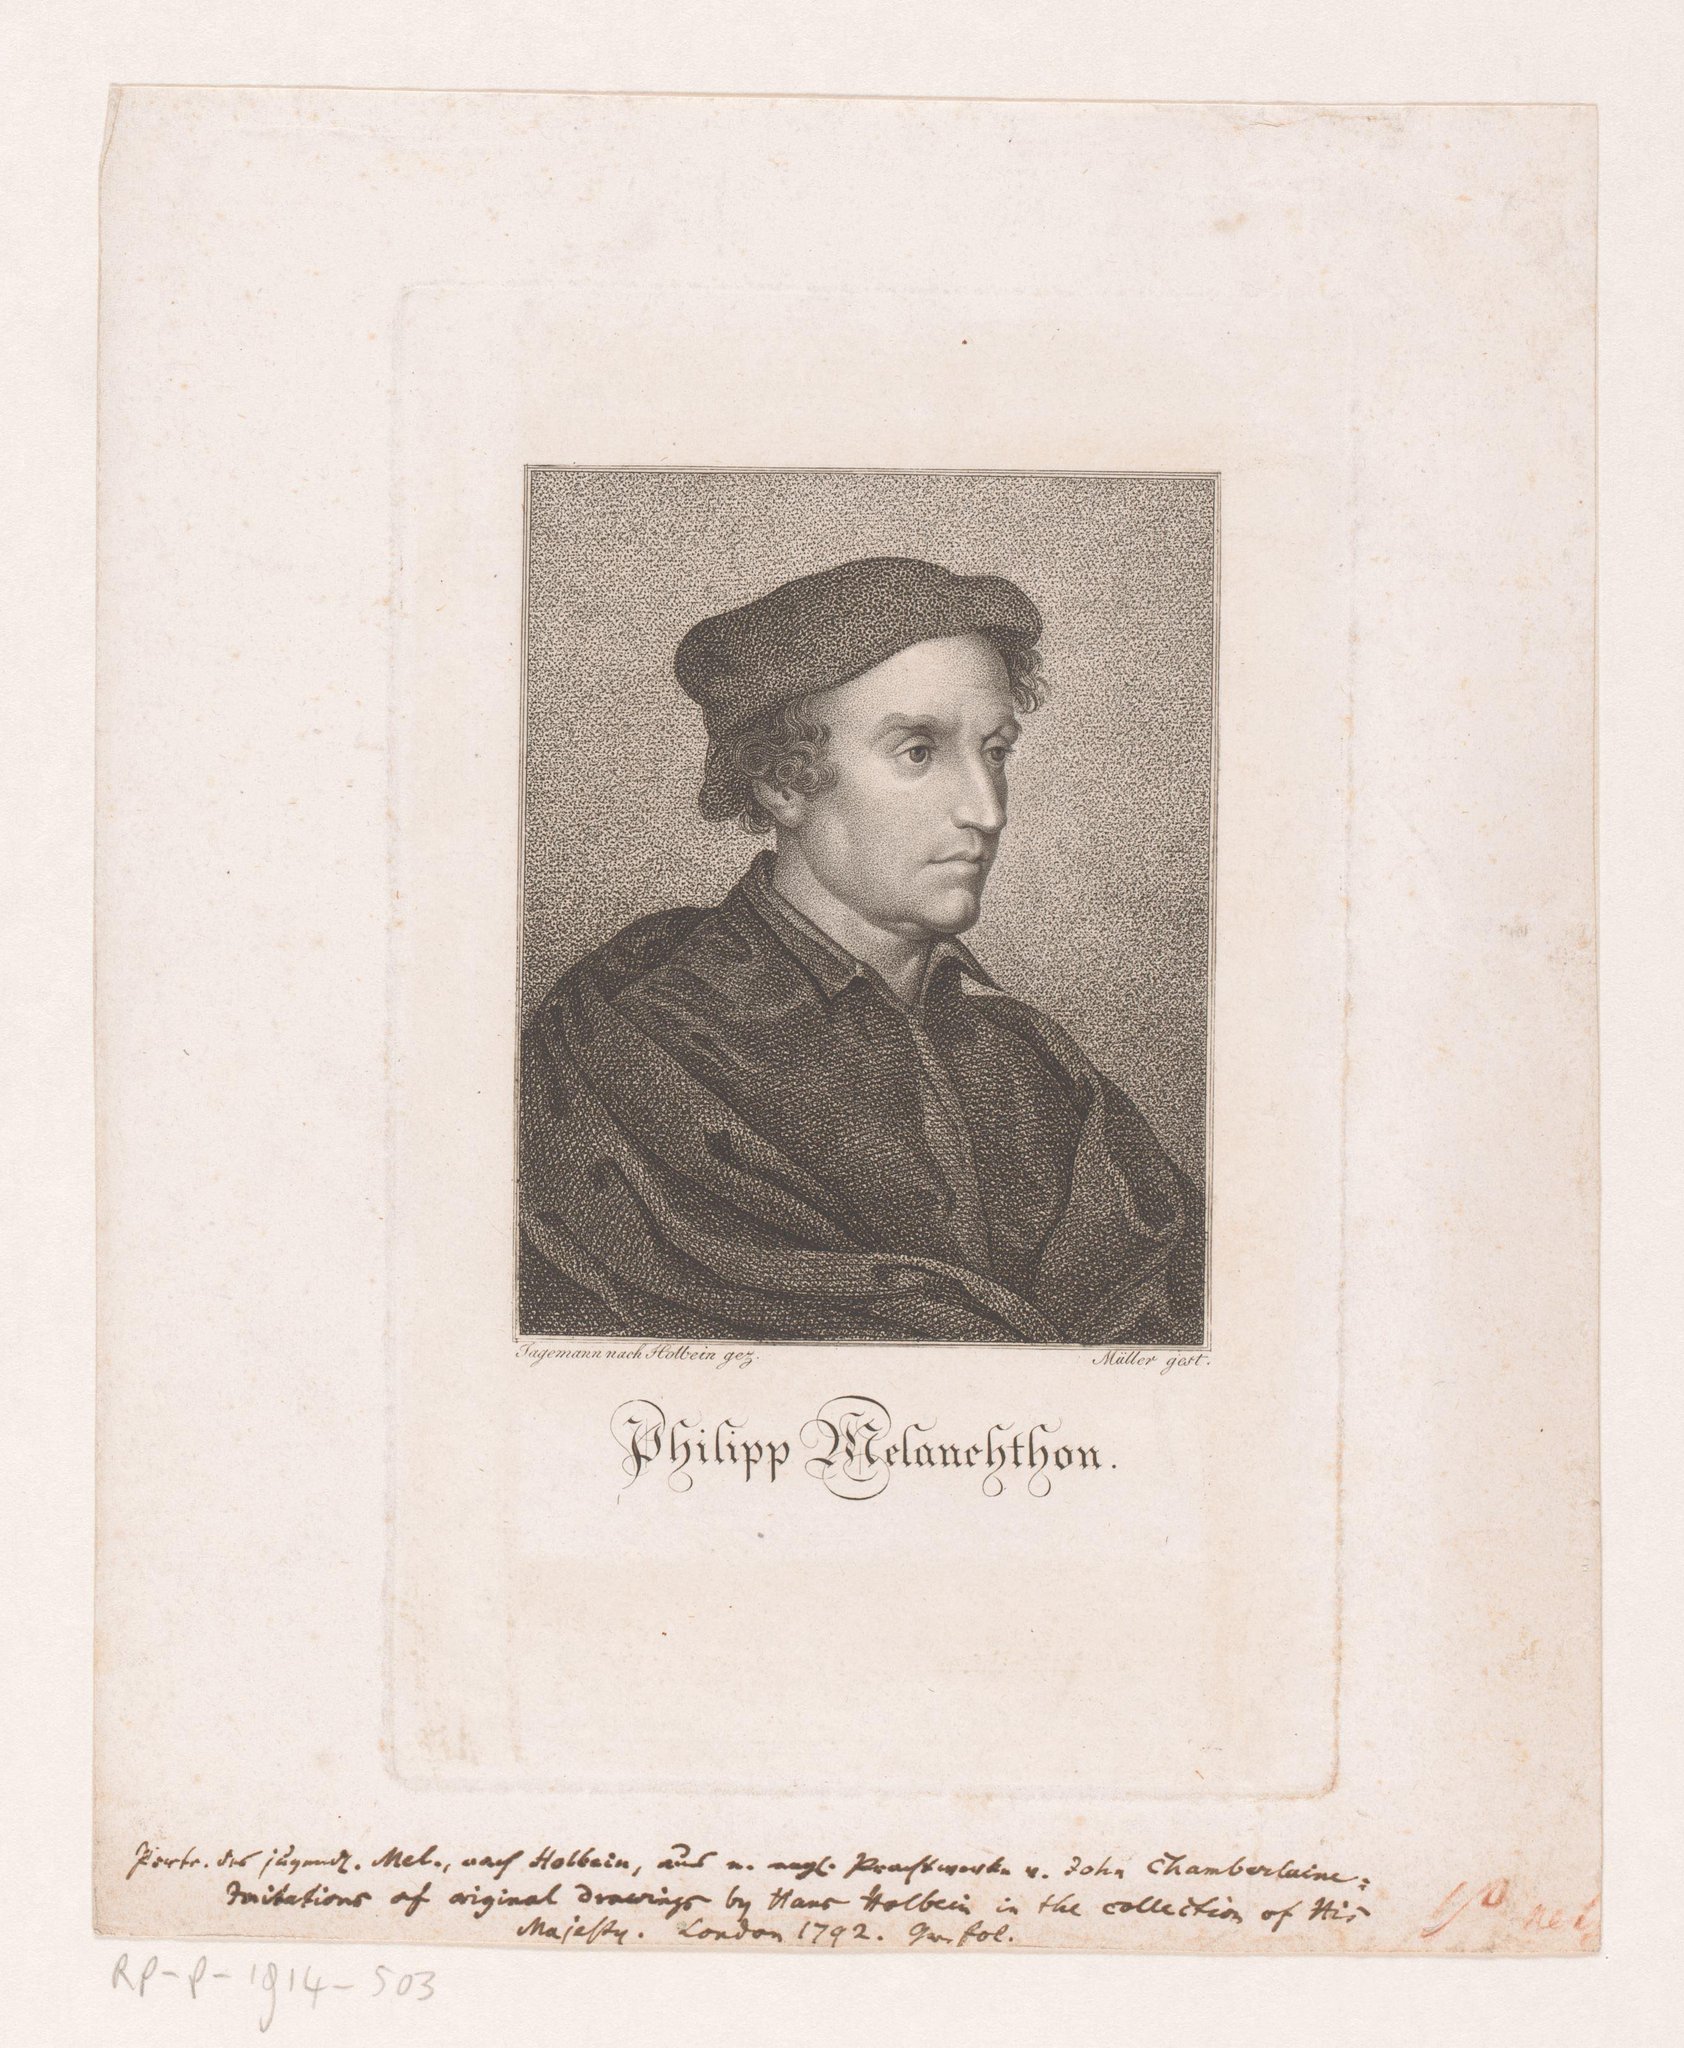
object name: print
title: Portret van Philipp Melanchton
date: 1776-1824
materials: paper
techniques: engraving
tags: historical persons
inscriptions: collector's mark: Lugt 2228